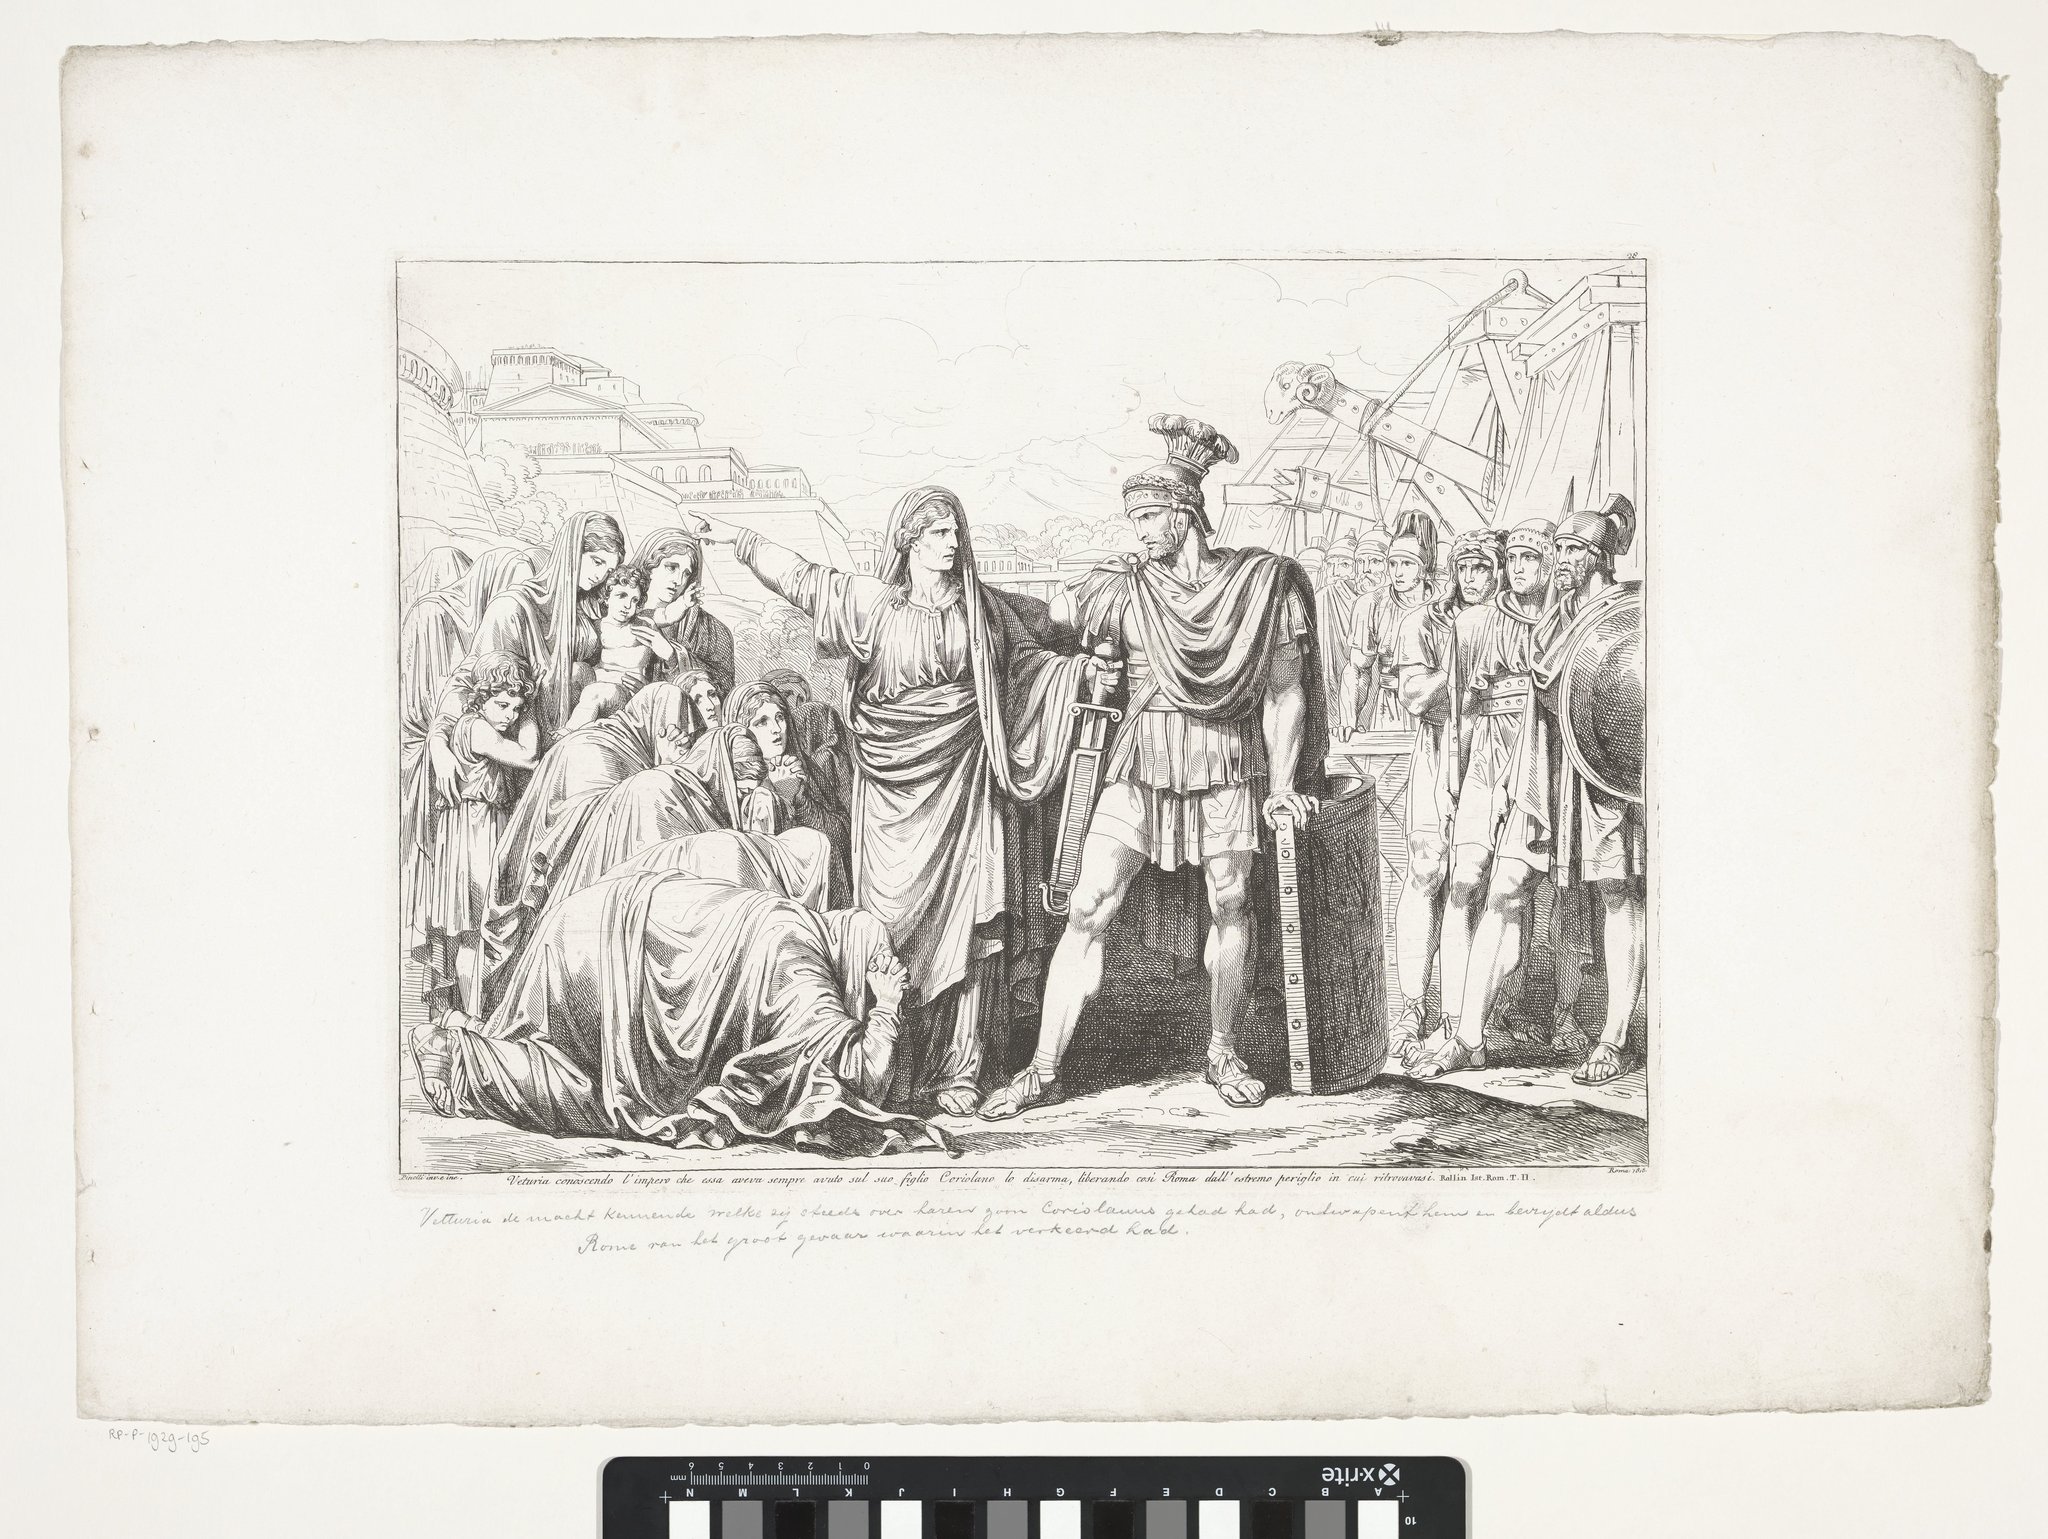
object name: print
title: Geschiedenis van het Romeinse Rijk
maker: bartolomeo pinelli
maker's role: draughtsman, print maker, sculptor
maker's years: 1781-1835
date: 1818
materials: paper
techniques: etching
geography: rome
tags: (story of) coriolanus, veturia, mother of coriolanus (one of the nine worthiest women), coriolanus (c. or cn. marcius) is met by his wife volumnia (alternatively called vergilia) with their two small sons, and his mother veturia (alternatively called volumnia); they entreat him not to fight any more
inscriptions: inscription: ‘Vetturia de macht kennende welke zij steeds over haren zoon Coriolanus gehad had, ontwapent hem en bevrijdt aldus / Rome van het groot gevaar waarin het verkeerd had.’, collector's mark: Lugt 2228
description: Gaius Marcius Coriolanus wordt ontwapend door zijn moeder Veturia. Links een groep treurende vrouwen en kinderen. Rechts het leger van Coriolanus.